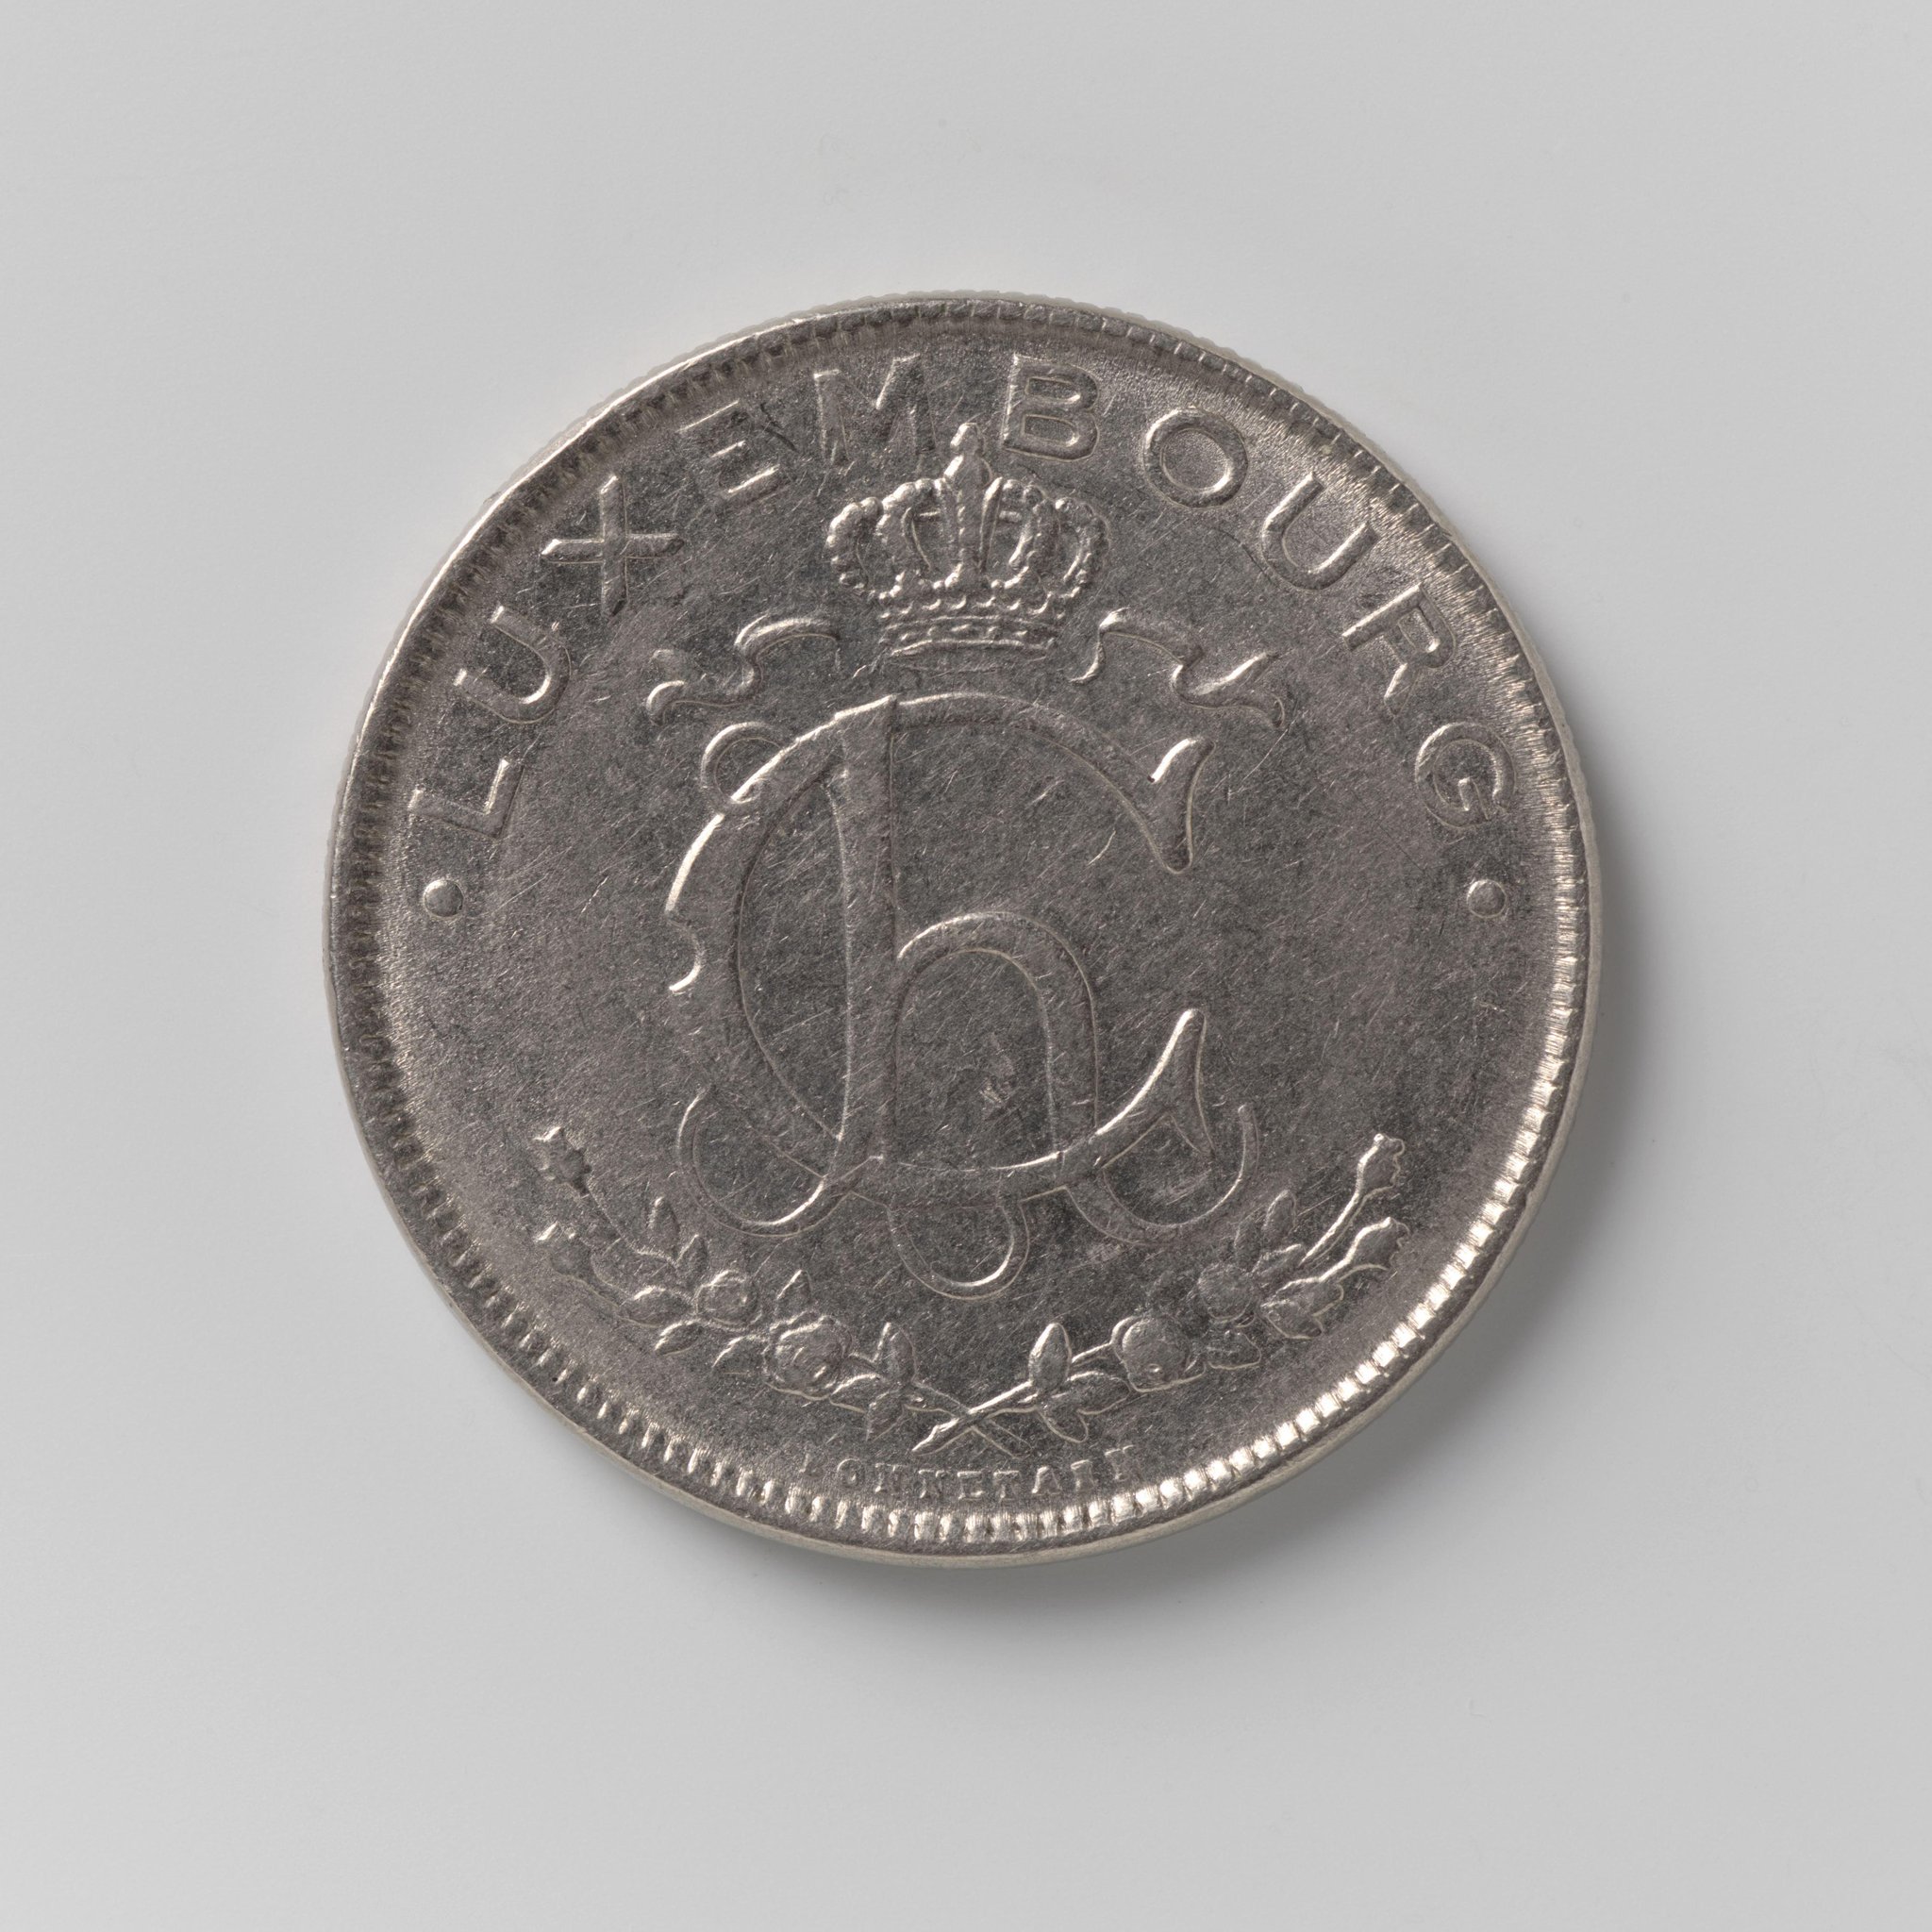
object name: coin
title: 2 francs uit Luxemburg van Charlotte, 1924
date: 1924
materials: nickel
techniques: striking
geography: brussels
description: Nikkelen munt. Voorzijde: gekroond monogram van de letters C en H. Keerzijde: tegen achtergrond van industriële activiteiten stoker met schep naar rechts. Rechts van hem waarde-aanduiding. Jaartal in afsnede. Kartelrand.